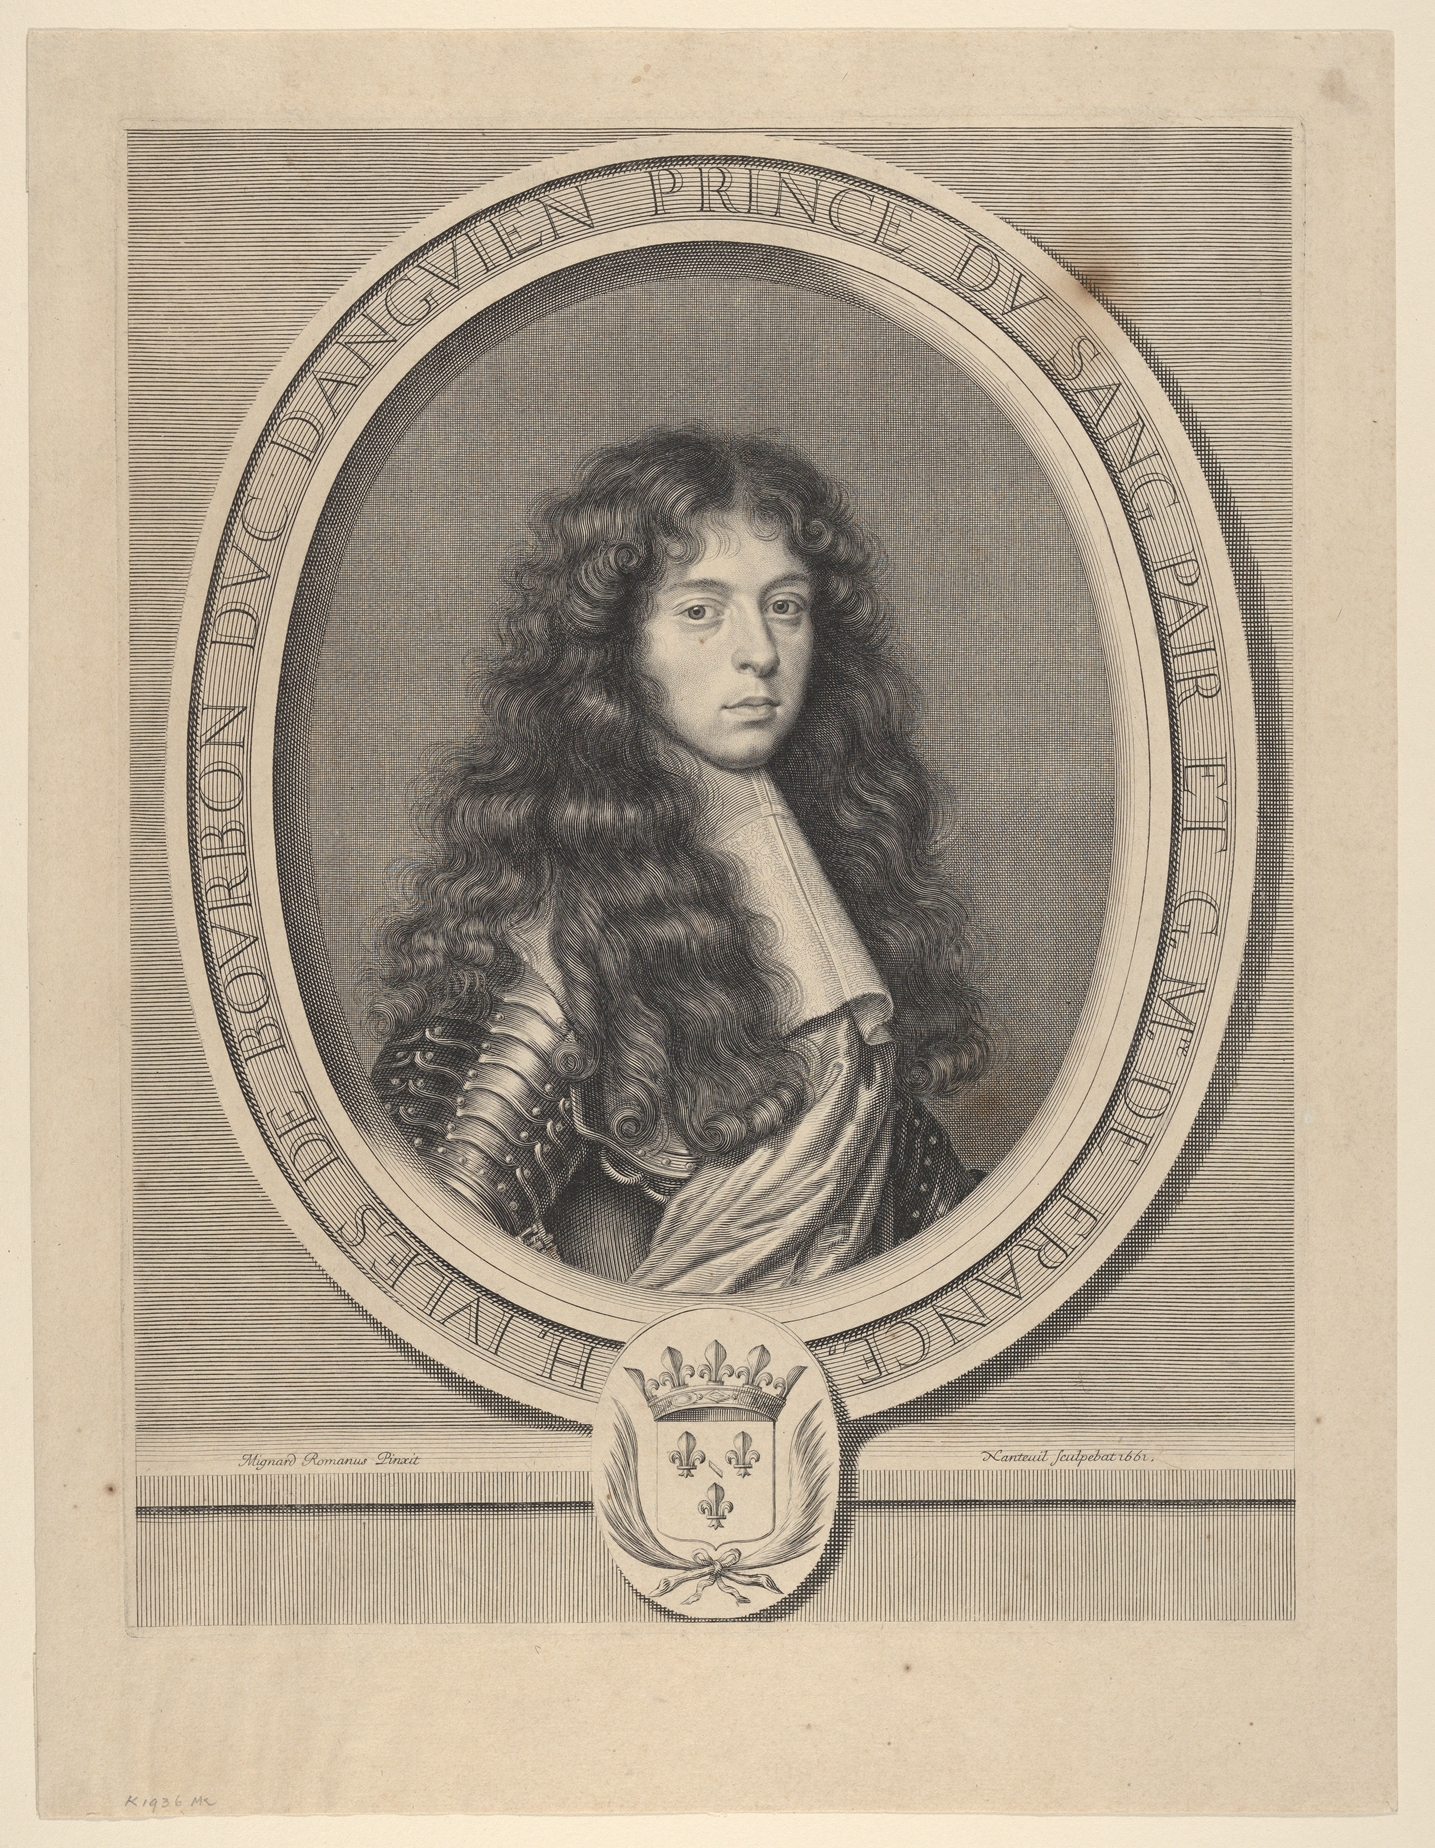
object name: print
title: Henri-Jules de Bourbon, duc d'Enghien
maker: robert nanteuil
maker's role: artist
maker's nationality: french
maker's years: 1623-1678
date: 1661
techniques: engraving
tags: men,portraits